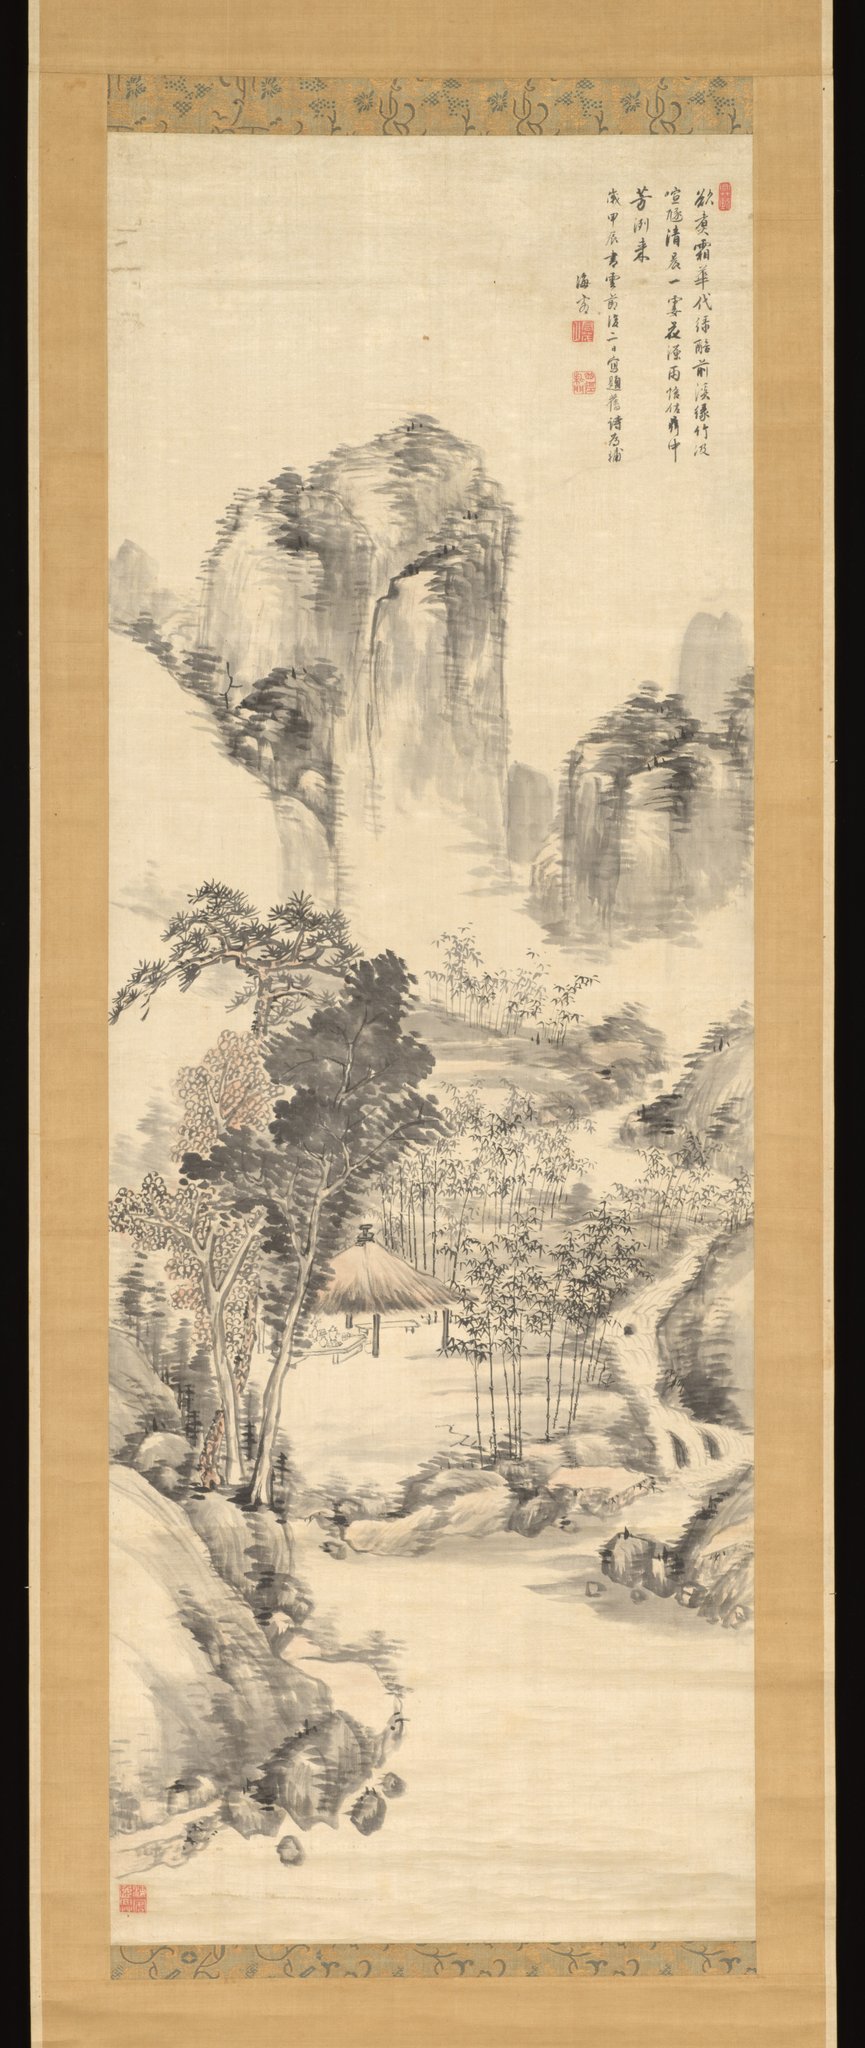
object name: hanging scroll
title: Making Sencha by a Bamboo Grove and Stream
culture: japanese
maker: nukina kaioku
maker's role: artist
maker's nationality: japanese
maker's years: 1778-1863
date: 1844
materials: ink, textile